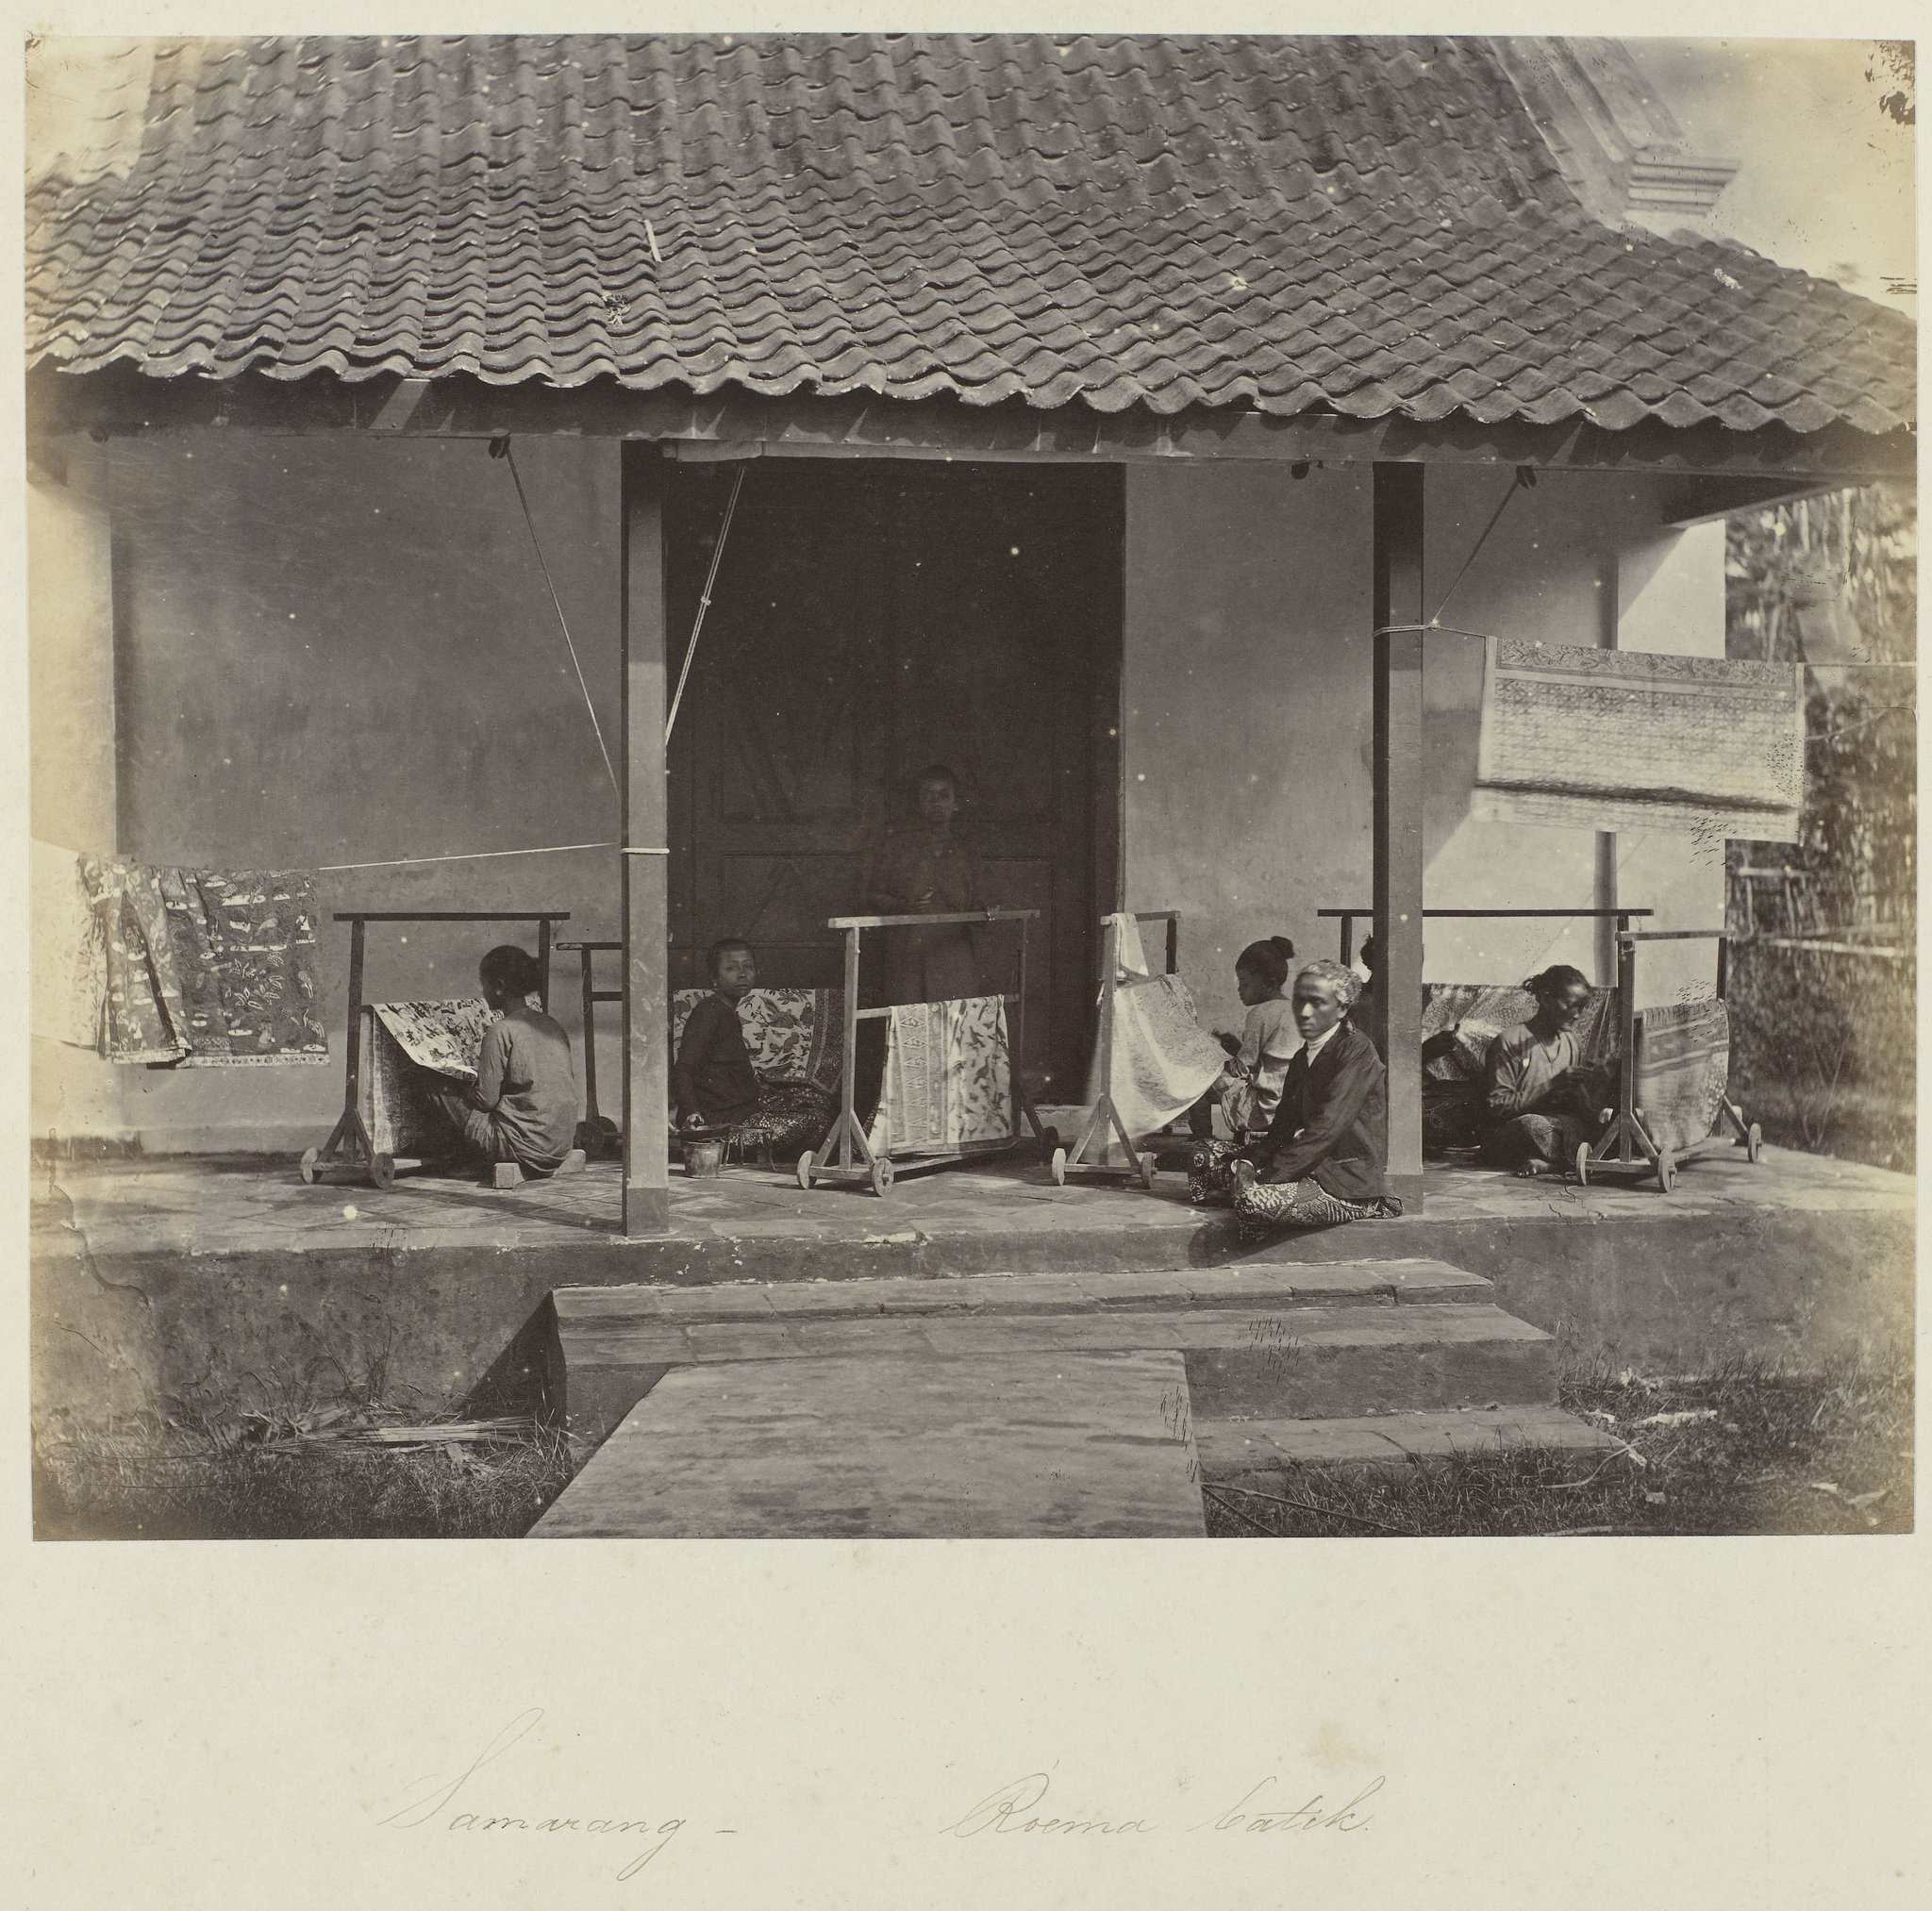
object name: photograph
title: Samarang - Roema batik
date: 1863-1869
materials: photographic support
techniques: albumen print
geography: semarang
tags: dyeing of cloth with pattern; batik-work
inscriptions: inscription: ‘Samarang - Roema batik’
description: Een groep batikkende vrouwen op de veranda voor een huis te Semarang. Onderdeel van het groene fotoalbum met foto's van Java, uit het bezit van apotheker Specht-Grijp, die in 1865 vanuit Batavia naar Nederland terugkeerde.